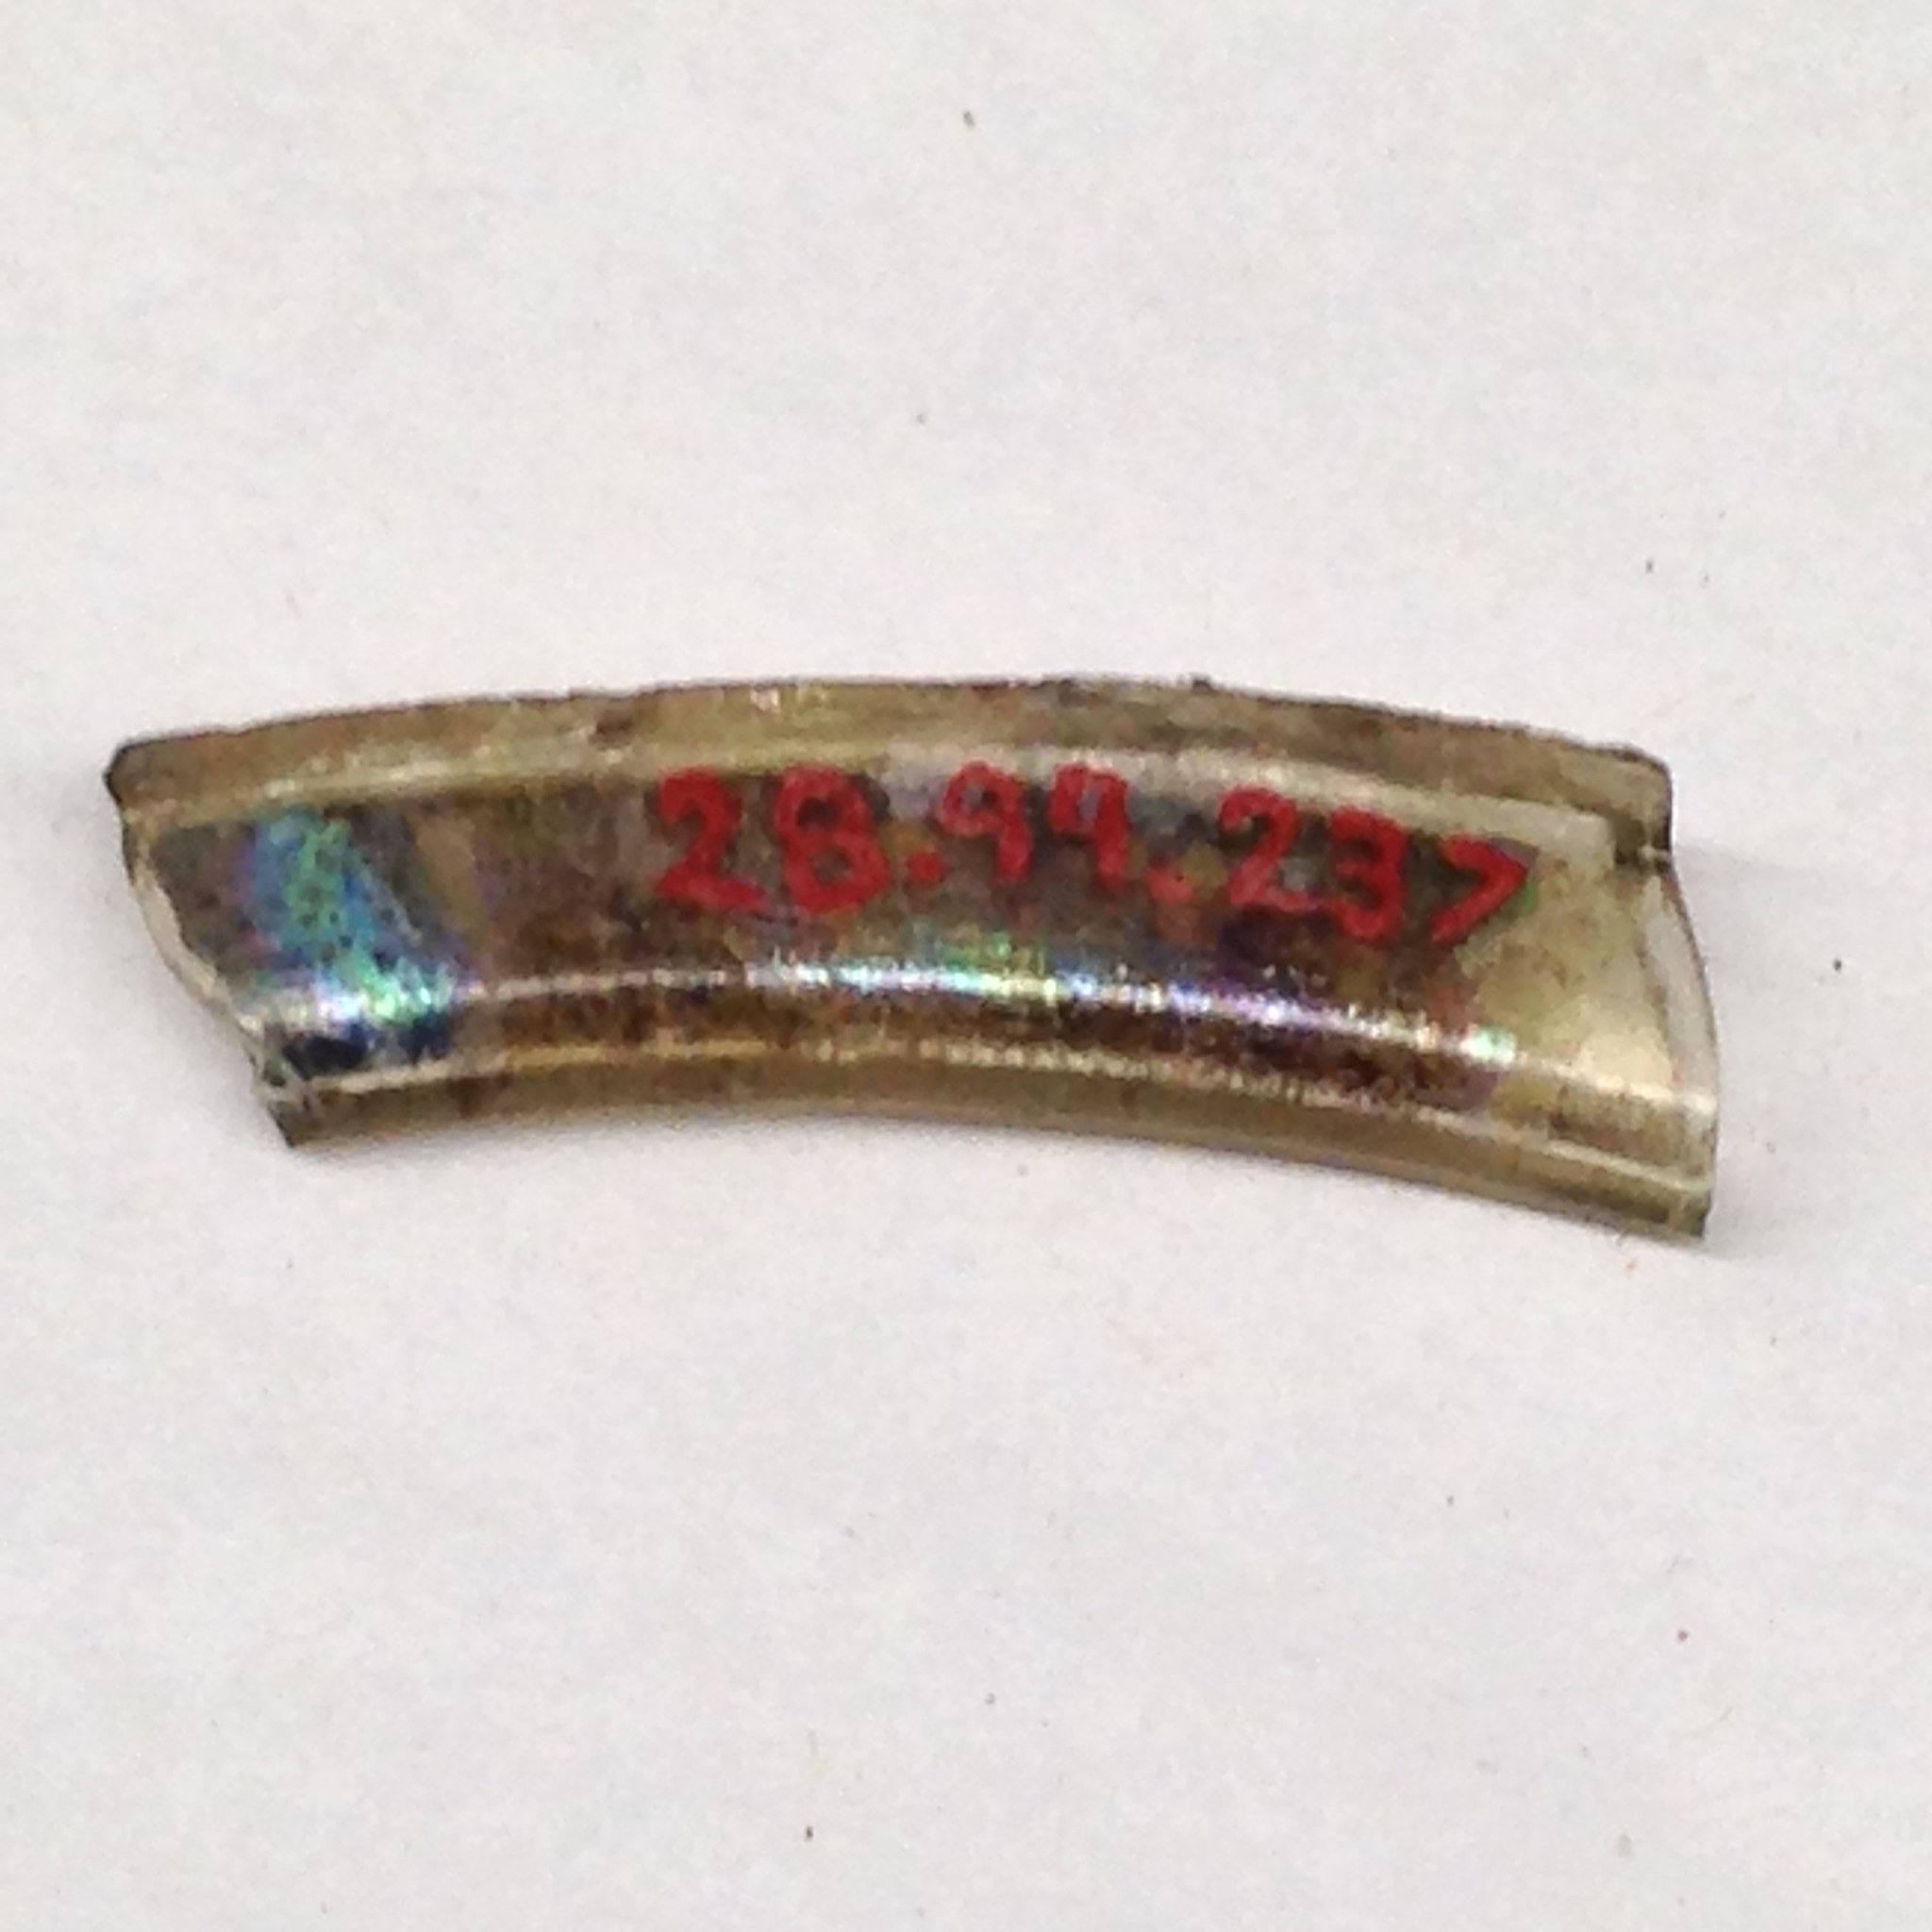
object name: fragment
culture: european or middle eastern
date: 1150-1250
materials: ceramic, glass